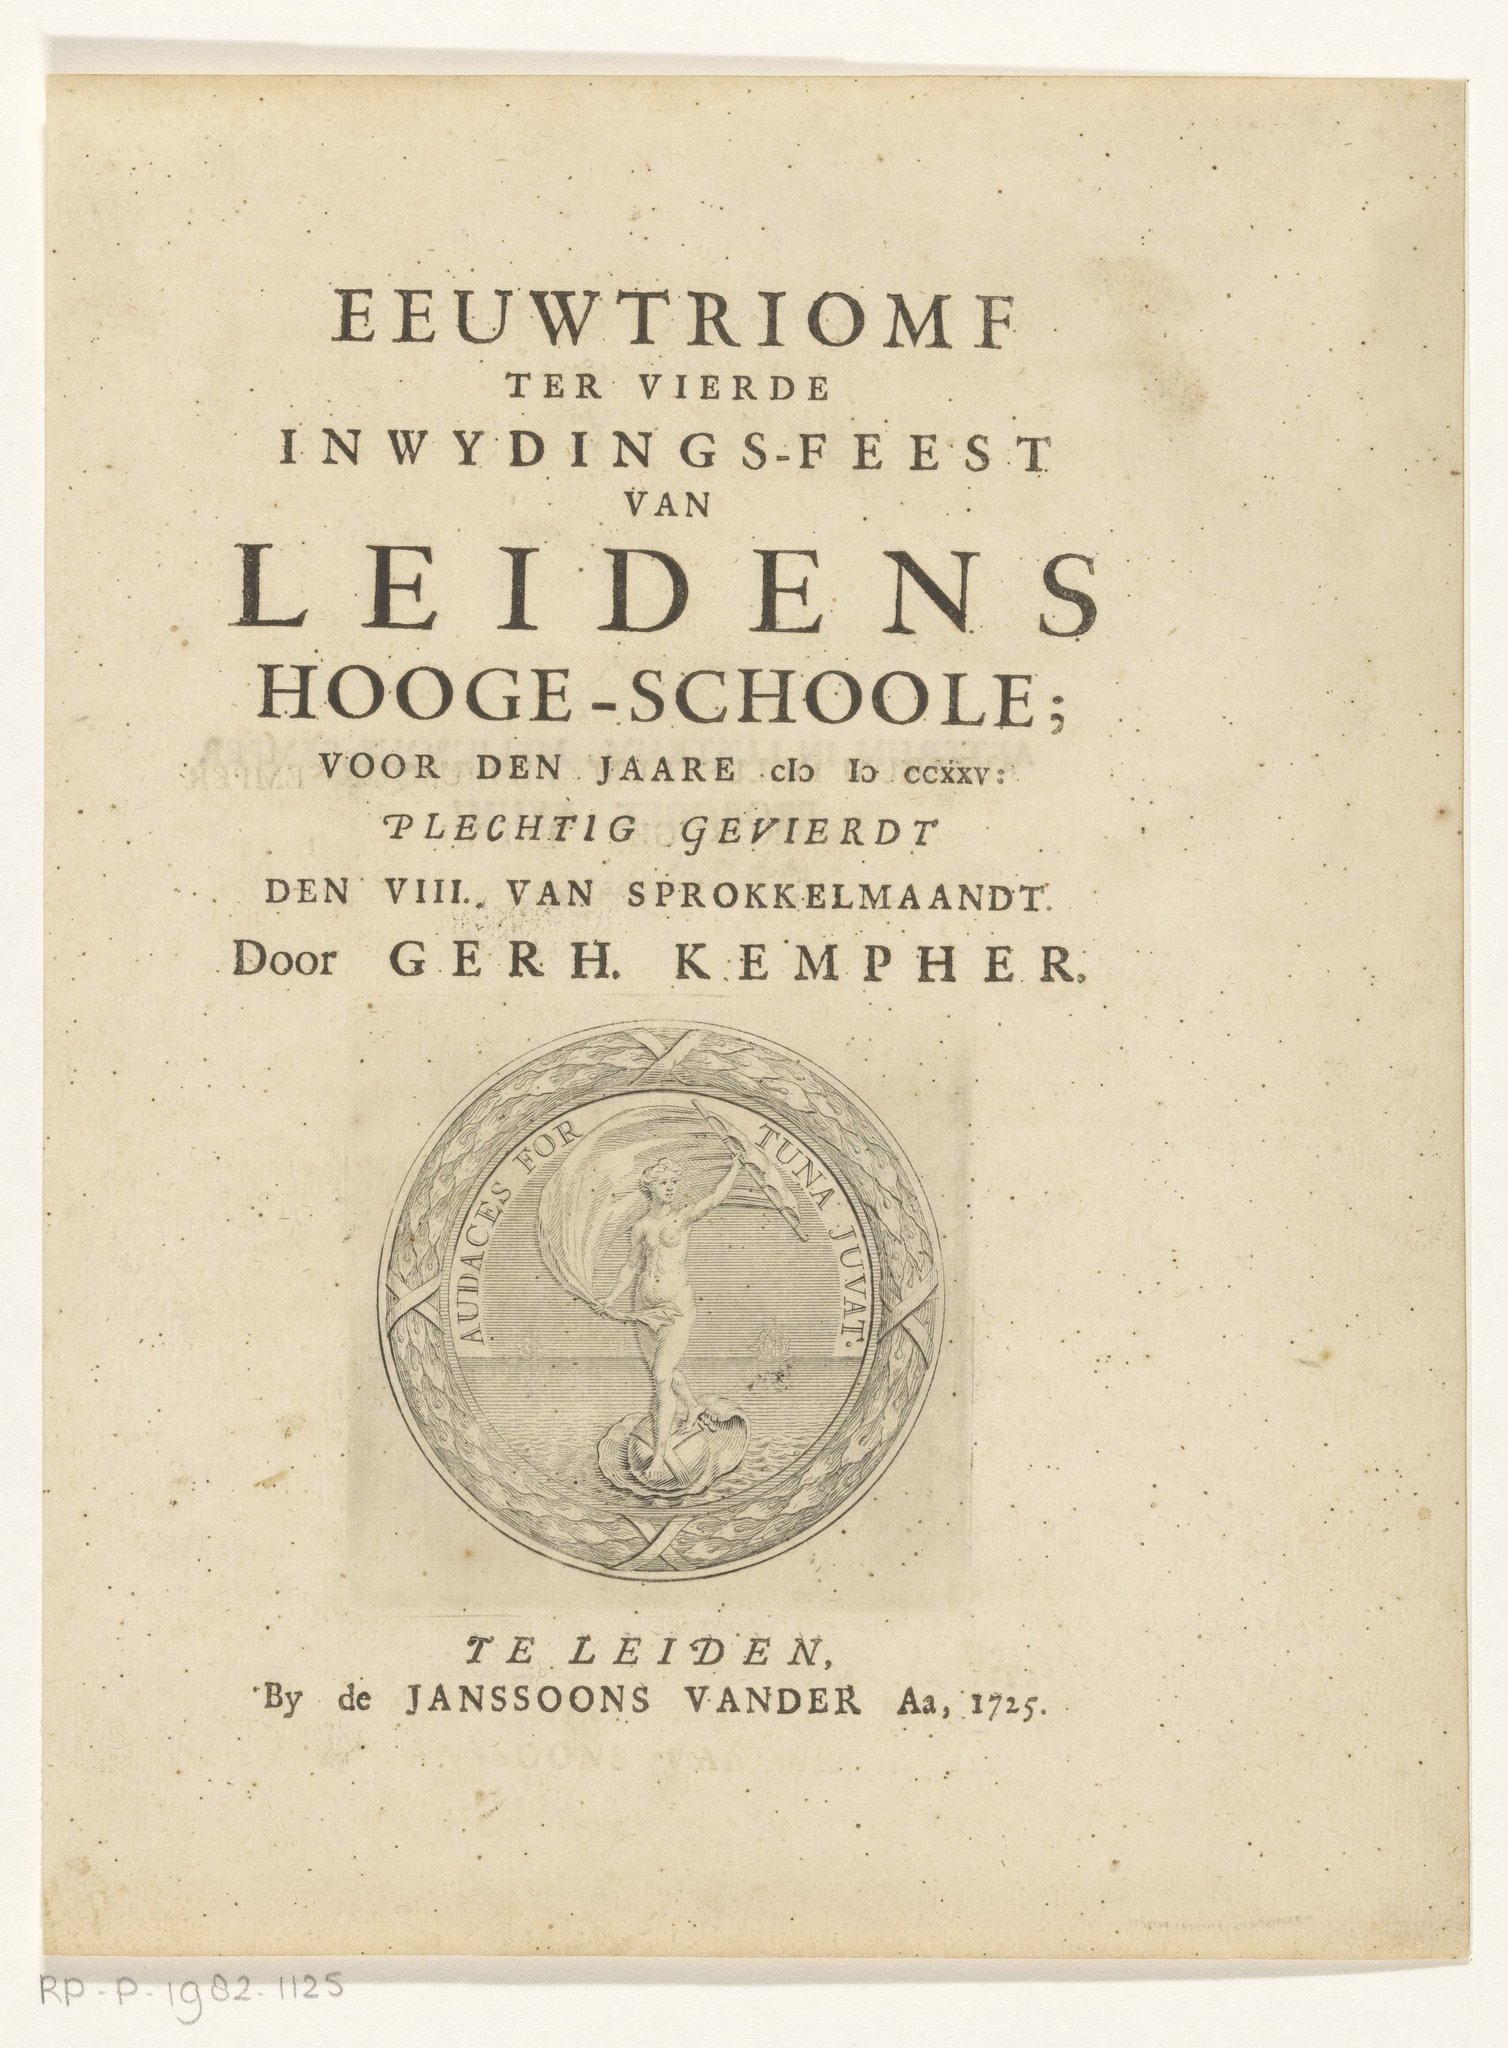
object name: titelblad, titelpagina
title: Venus door de wind meegevoerd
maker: Anonymous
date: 1725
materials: paper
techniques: engraving, letterpress printing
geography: leiden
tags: device (trade-mark of printer or publisher), venus, standing on a shell, sails with her veil over the water (alternatively she is riding on a dolphin): venus marina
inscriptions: collector's mark: Lugt 2780, collector's mark: Lugt 2228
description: Venus staat op een rijksappel op haar schelp op zee en houdt haar gewaad in de wind zodat het dient als een zeil. In de achtergrond vaart een schip op zee. Rondom het motto Audaces fortuna juvat. Drukkersmerk van de Gebroeders Janssoon van der Aa.